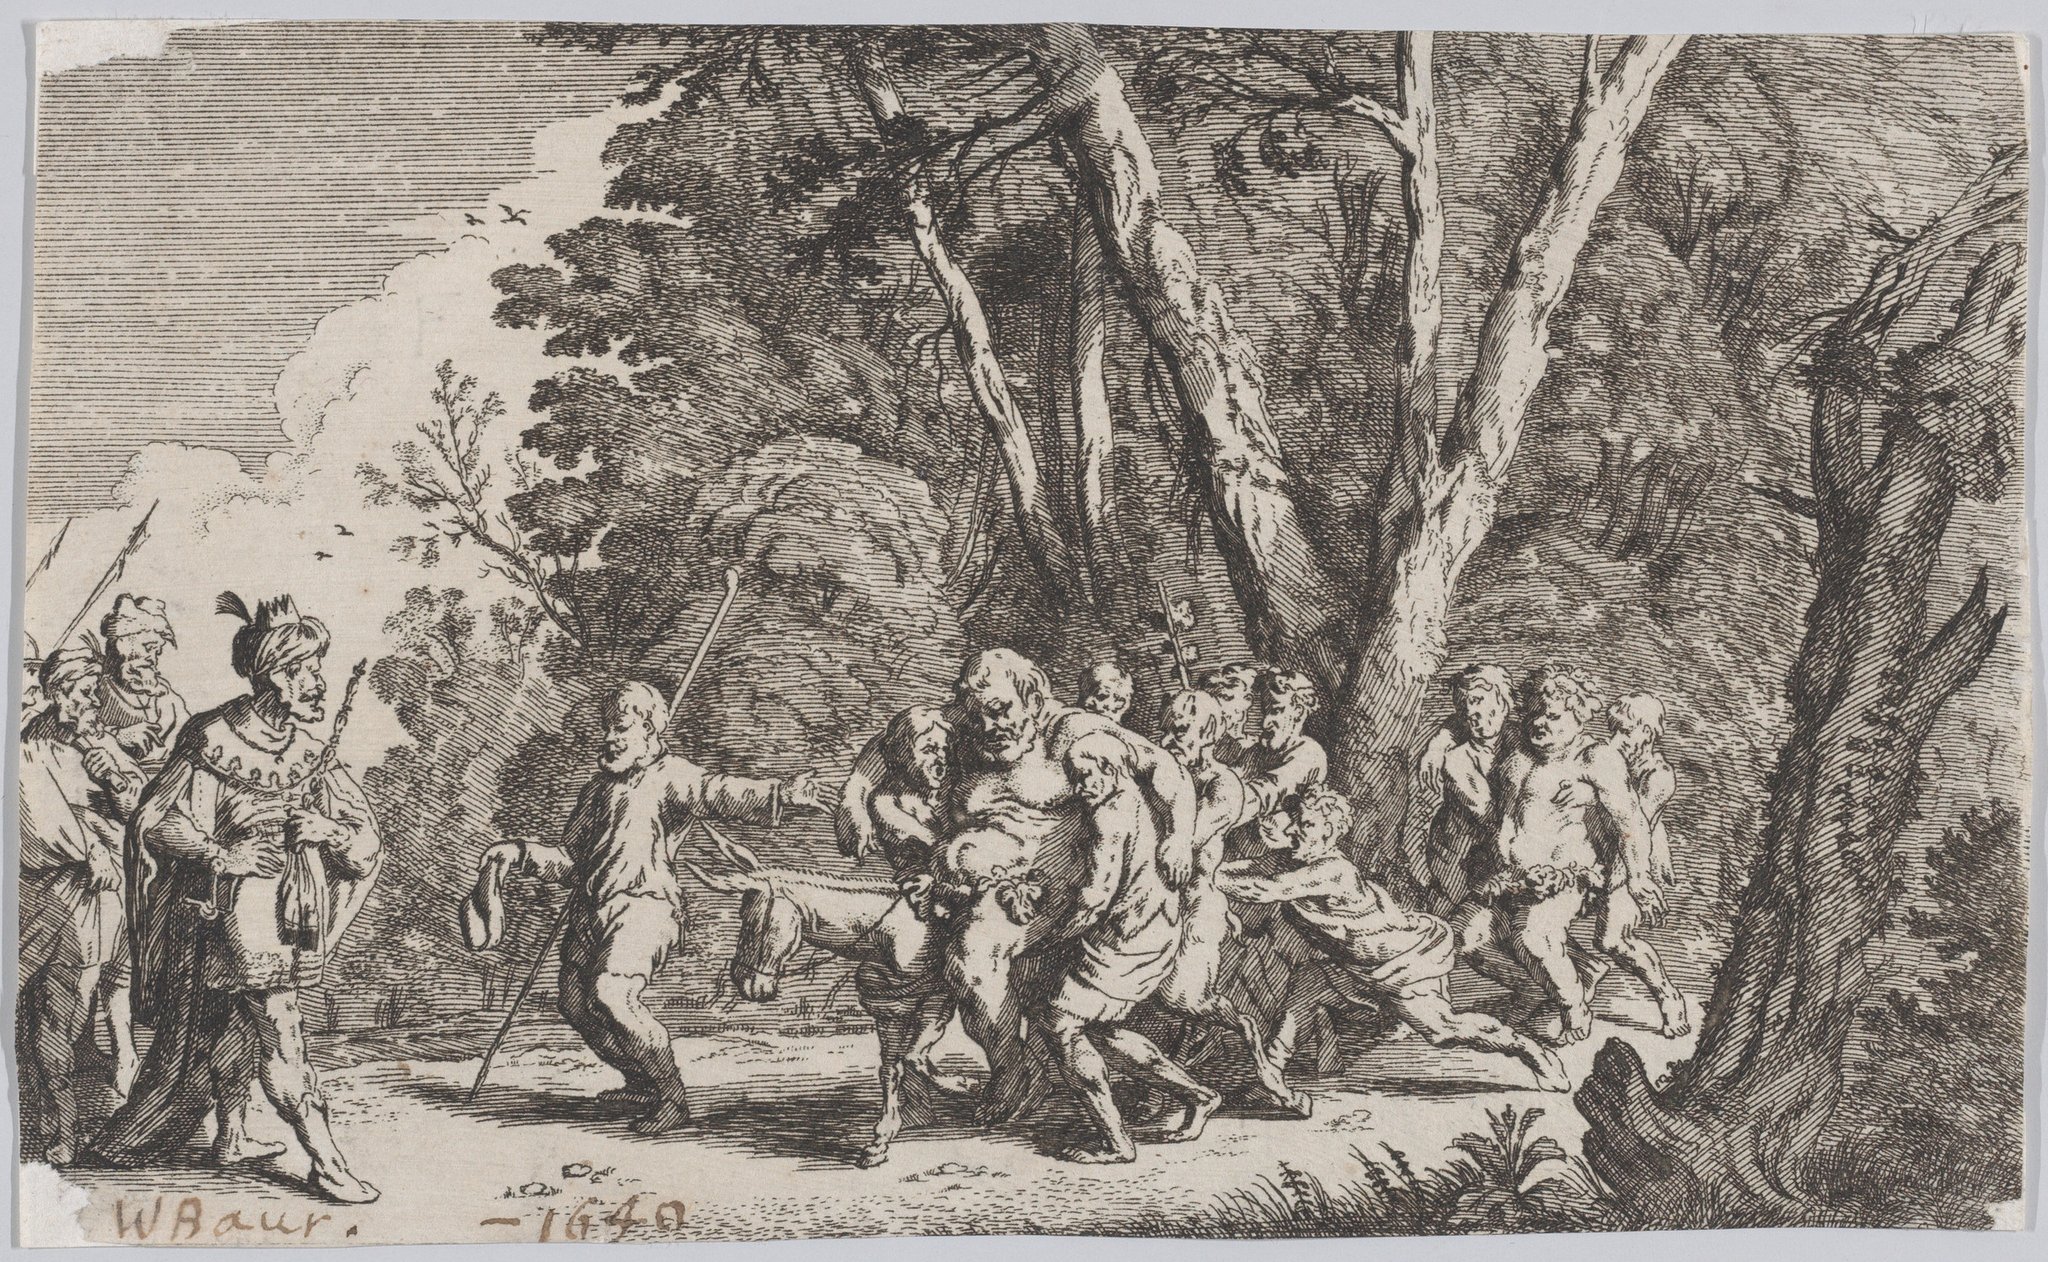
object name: print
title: Plate 101: Silenus before King Midas, from 'Ovid's Metamorphoses'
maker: johann wilhelm baur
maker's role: artist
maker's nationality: german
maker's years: 1607-1642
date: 1641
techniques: etching